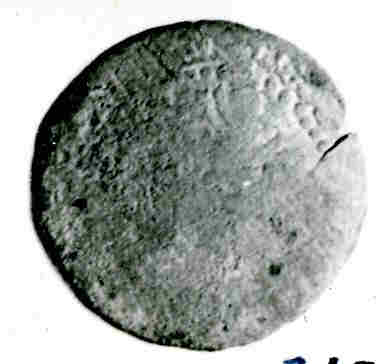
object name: coin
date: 1101-1200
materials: copper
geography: iran